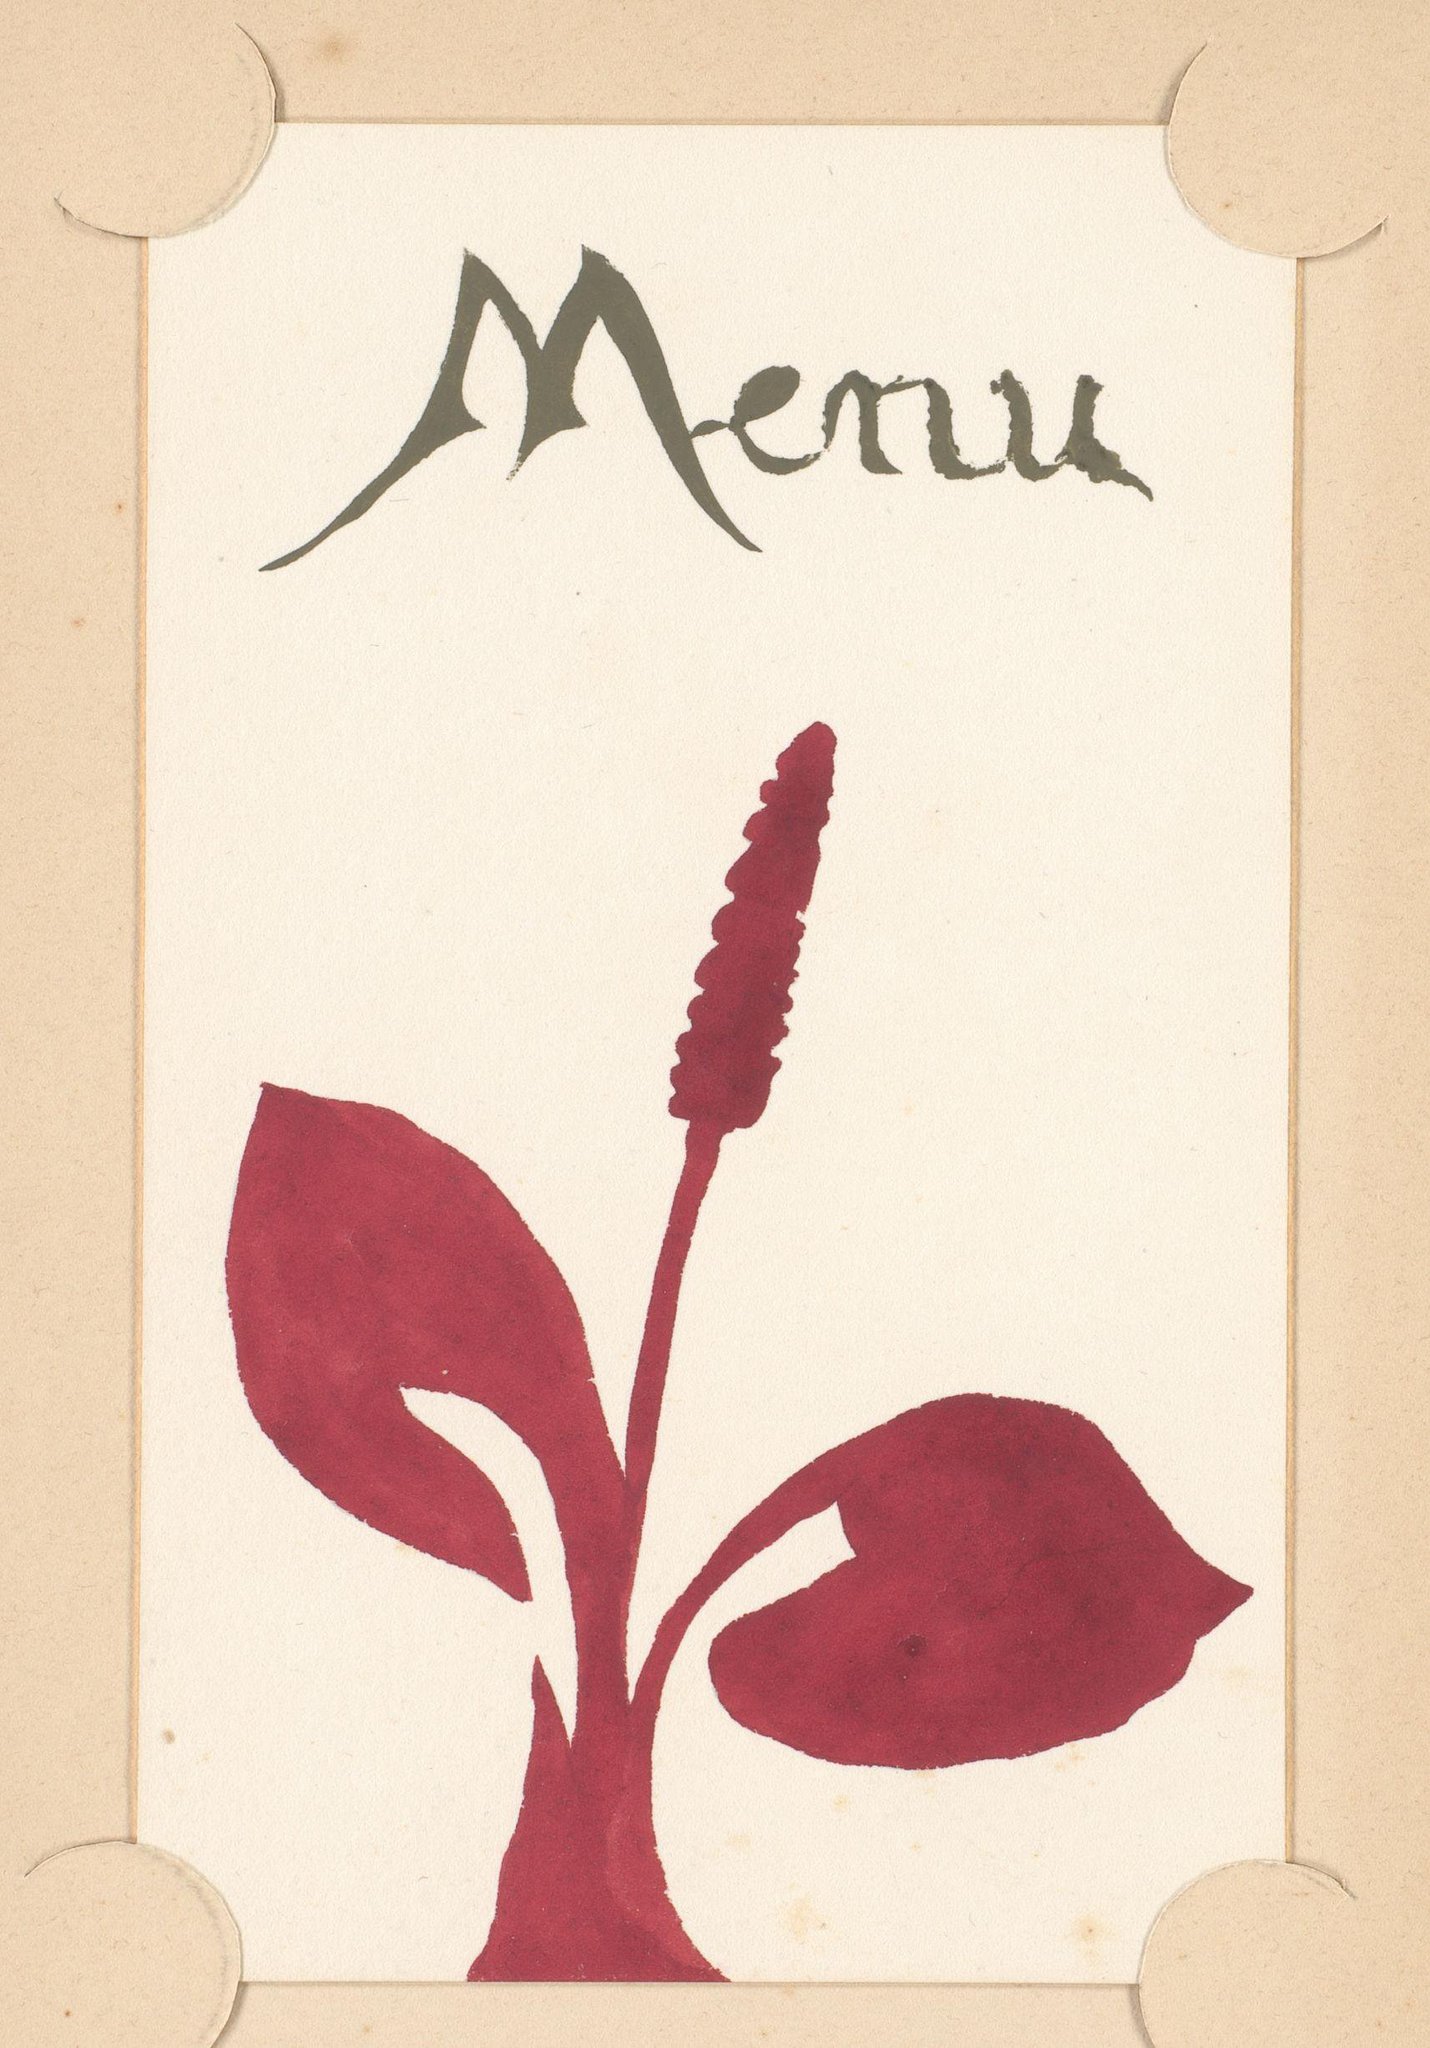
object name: menu, menukaart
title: Menukaart met botanische decoratie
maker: theo colenbrander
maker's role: draughtsman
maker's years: 1841-1930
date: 1851-1930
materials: paper, pencil, paint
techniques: brush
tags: plants (in general)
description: Groot het woord 'Menu' met daaronder het silhouet van een plant. Deze tekening maakt deel uit van een album.